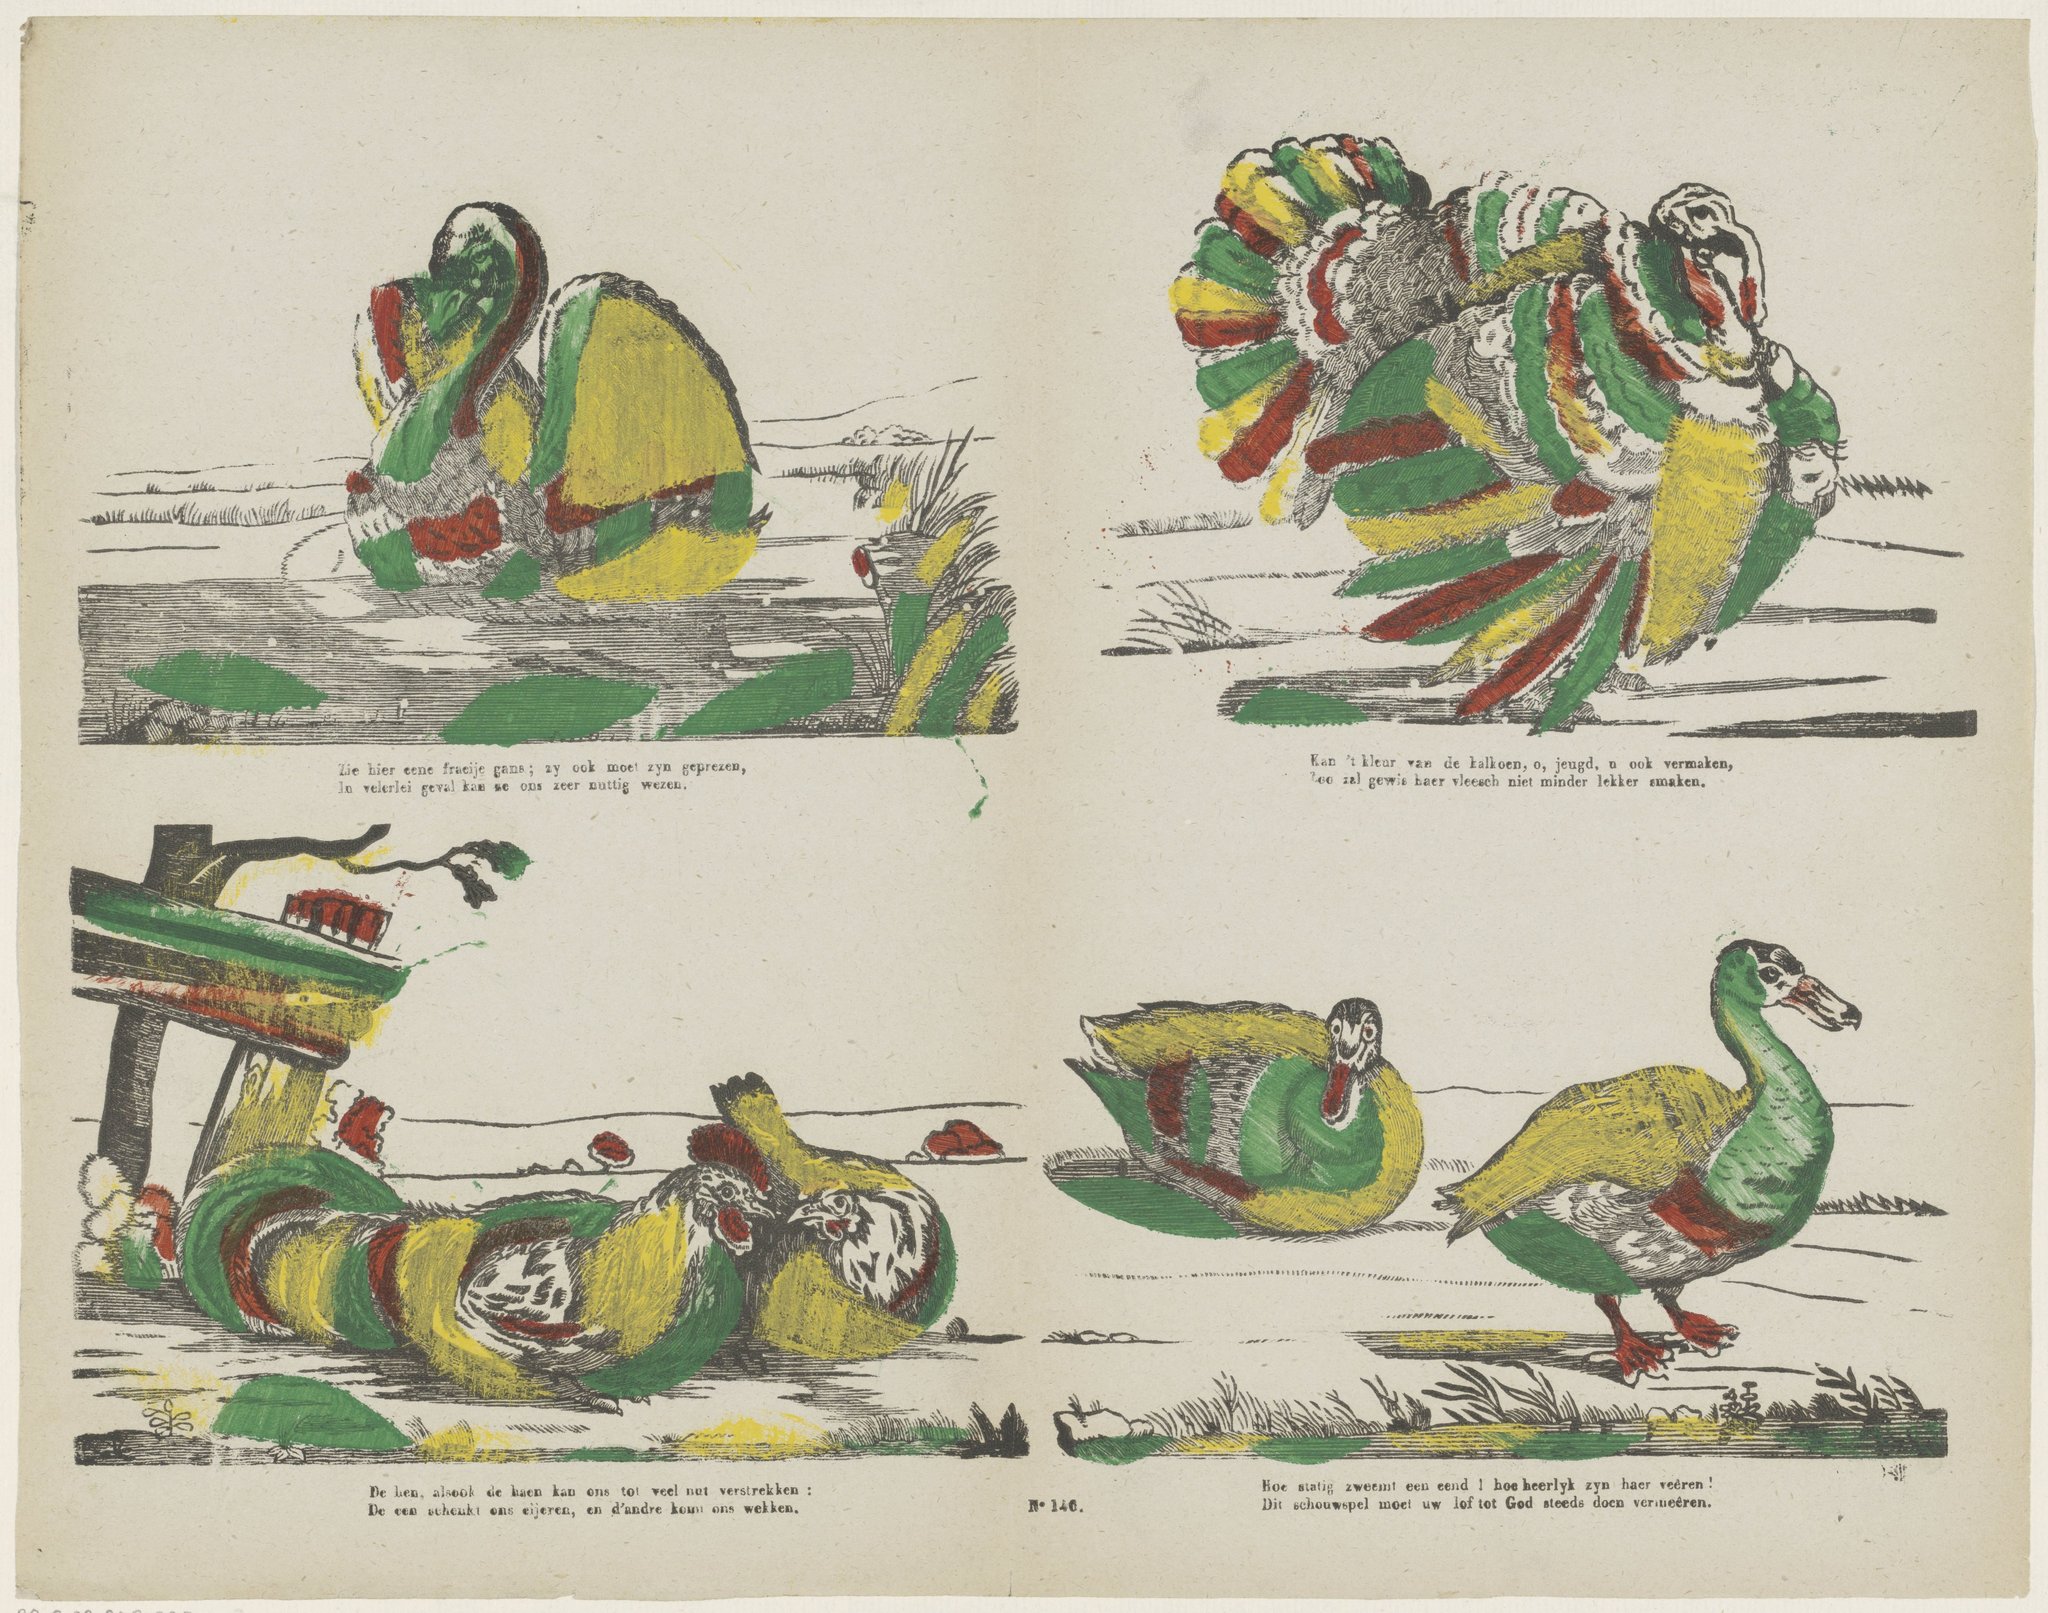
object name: print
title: Pluimvee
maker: Anonymous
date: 1833-1900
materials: paper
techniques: colour, letterpress printing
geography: netherlands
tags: water-birds: swan, fowl (cock, hen, chicken, etc.), water-birds: duck, walker and runner birds: turkey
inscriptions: collector's mark: Lugt 2760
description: Blad met 4 voorstellingen van pluimvee: een zwaan, een kalkoen, een kip, een haan en eenden. Onder elke afbeelding een tweeregelig vers. Genummerd midden onder: No 146.